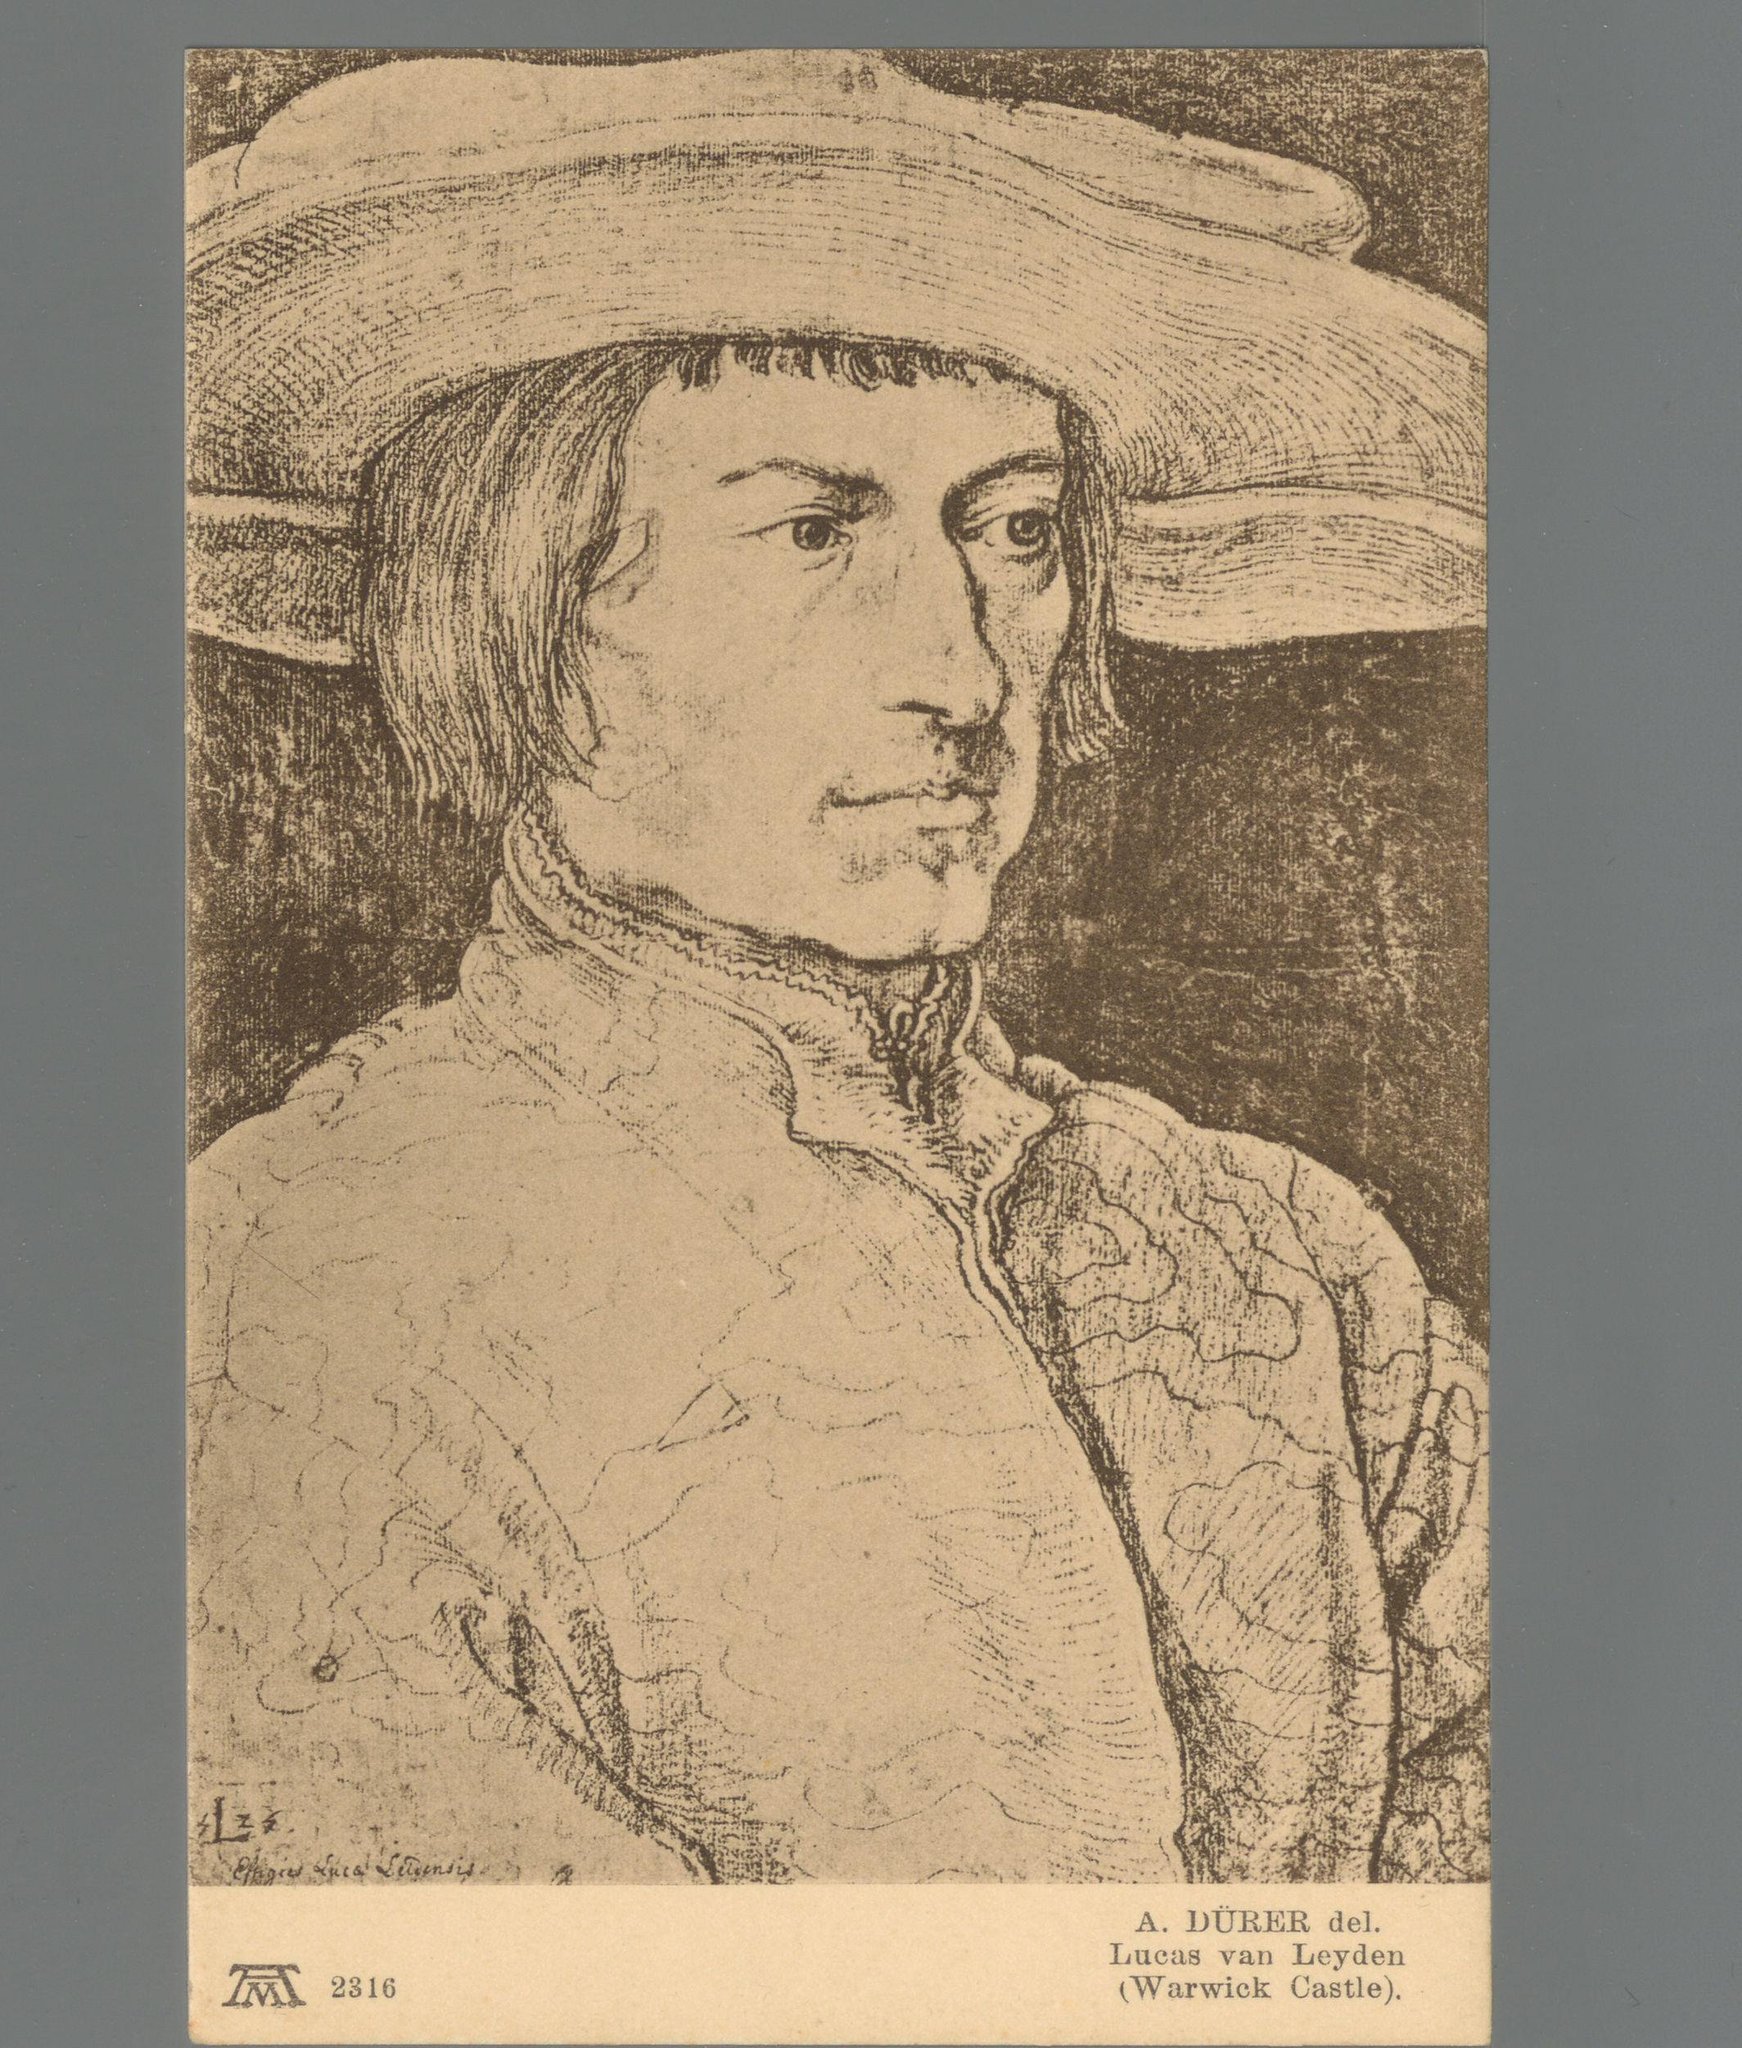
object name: reproduction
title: A. Dürer del. Lucas van Leyden (Warwick Castle)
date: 1905-1930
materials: cardboard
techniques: photograph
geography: munich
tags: painter, lucas van leyden, castle, portrait, self-portrait of painter, picture, painting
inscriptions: collector's mark: ‘AFE v S’